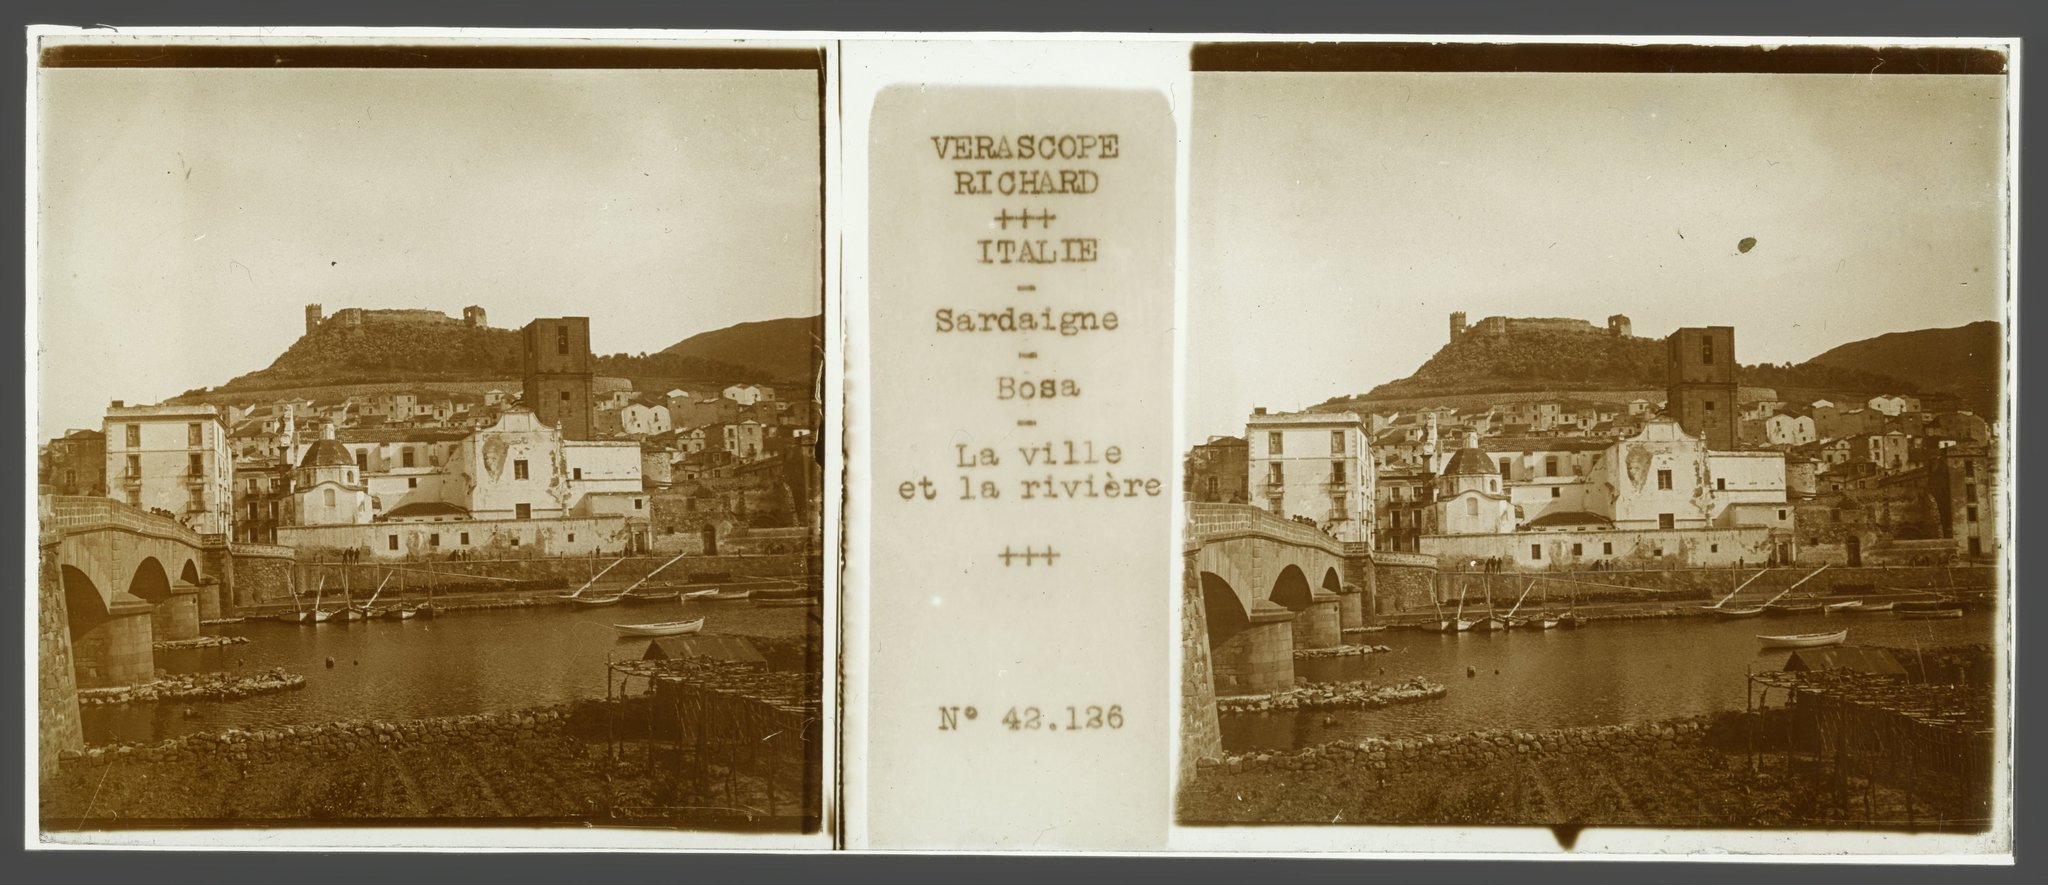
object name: stereoscopic photograph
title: Gezicht op de haven en de stad Bosa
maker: Anonymous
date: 1893-1920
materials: glass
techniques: gelatin silver transparency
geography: paris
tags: harbour, city-view in general; 'veduta'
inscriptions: number: ‘No 42.136’